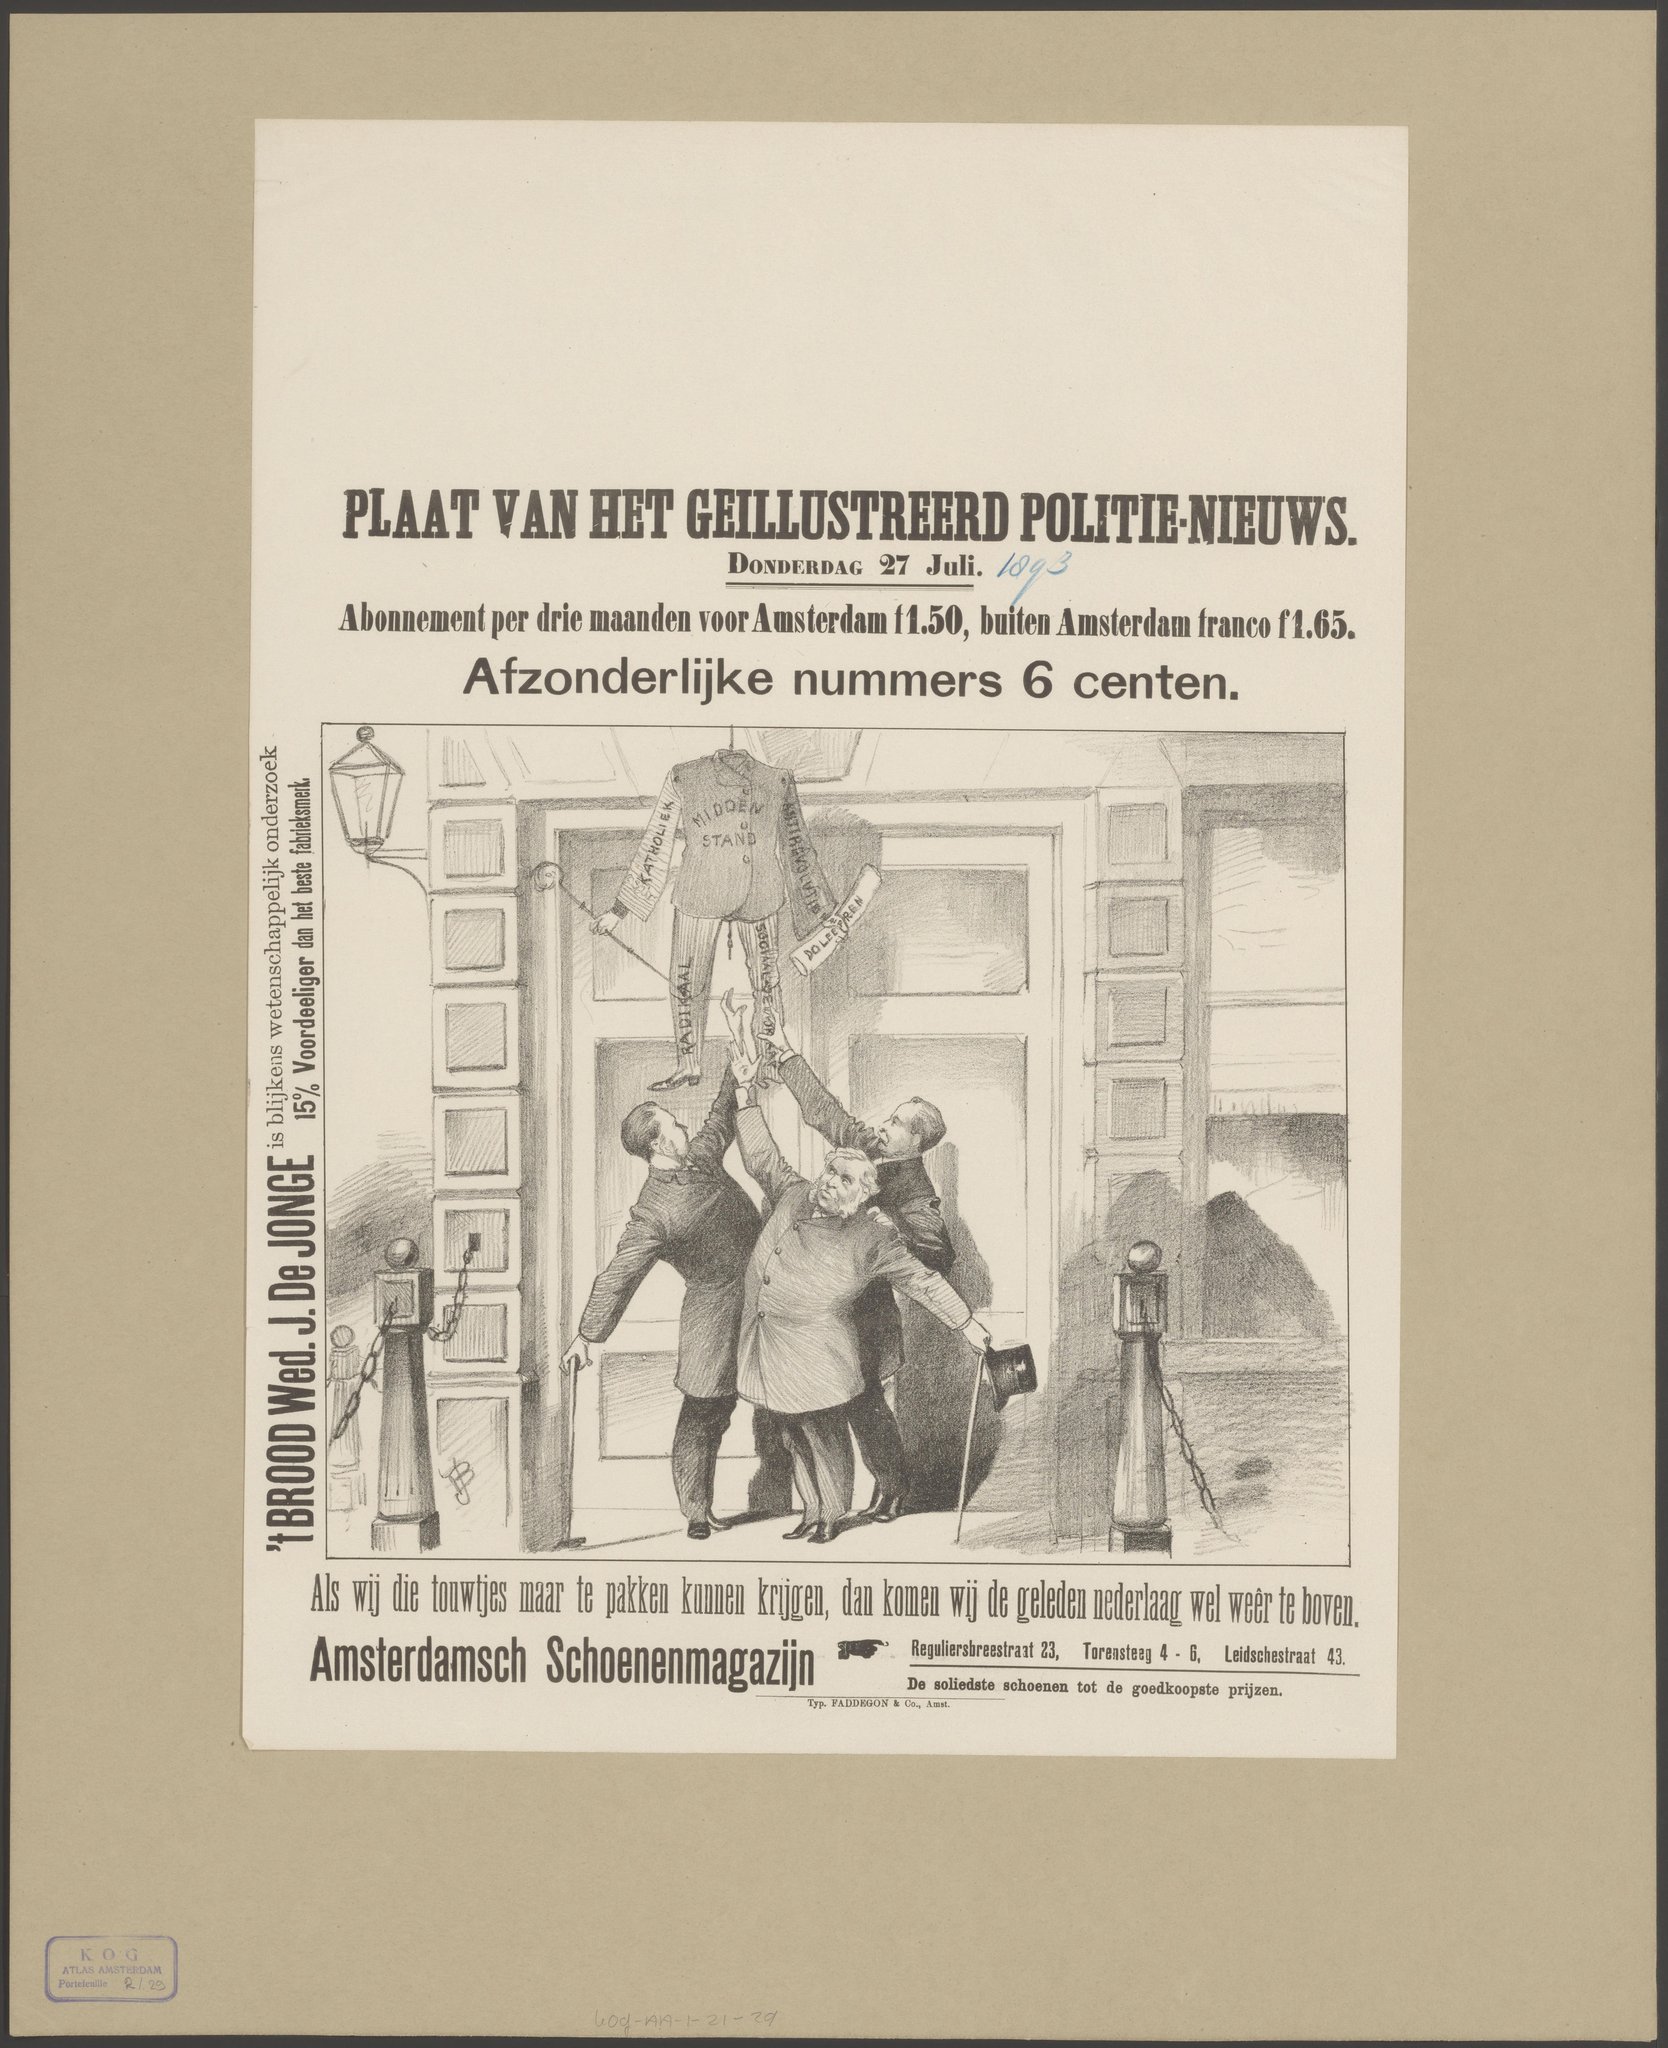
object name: cartoon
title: Als wij die touwtjes maar te pakken kunnen krijgen, dan komen wij de geleden nederlaag wel weêr te boven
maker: johan braakensiek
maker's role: draughtsman, print maker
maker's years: 1858-1940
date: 1893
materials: paper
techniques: letterpress printing, lithograph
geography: amsterdam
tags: insignia of bishop, e.g. mitre, crozier, (playing with) dolls, political caricatures and satires, amsterdam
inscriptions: collector's mark: Lugt 1641b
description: Onderwerpsrubriek binnen de Atlas Amsterdam: Kiesverenigingen, Politieke partijen.